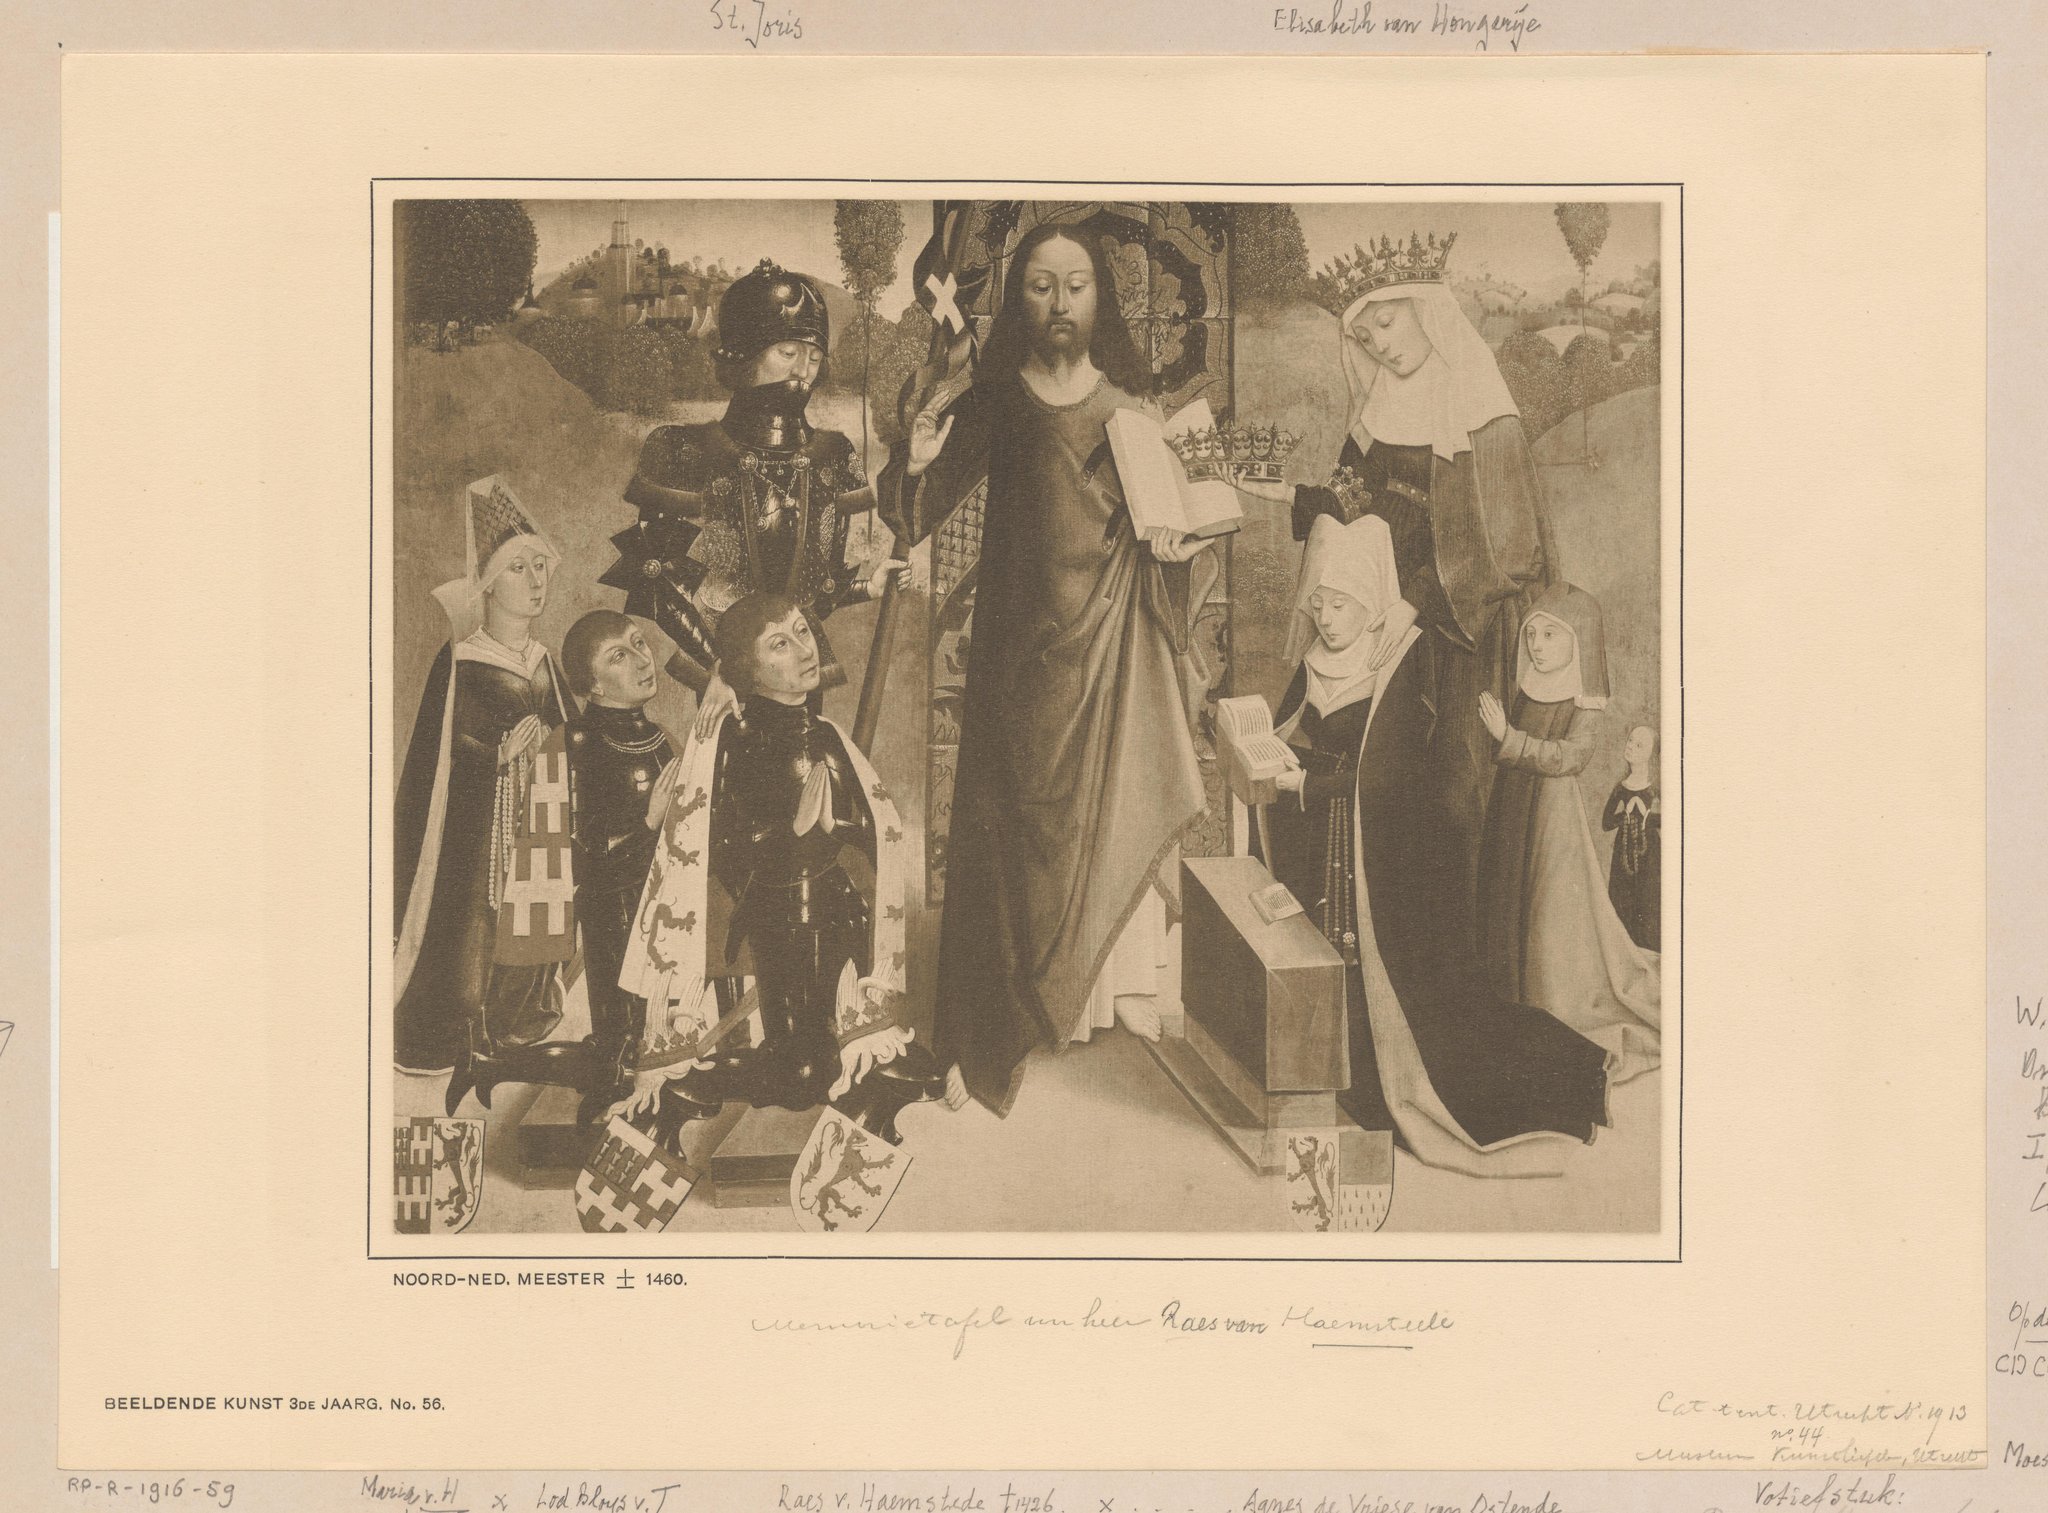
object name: photomechanical print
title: Memorietafel van Heer Raas van Haemstede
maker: Anonymous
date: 1900-1916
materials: paper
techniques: photograph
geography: northern netherlands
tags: 'salvator mundi', making a blessing gesture; an orb in his hand or at his feet, historical persons - bb - woman, historical persons, armorial bearing, heraldry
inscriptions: collector's mark: Lugt 2228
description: Ter weerszijden van Christus knielen Raas van Haamstede, zijn echtgenote, kinderen en schoonzoon.